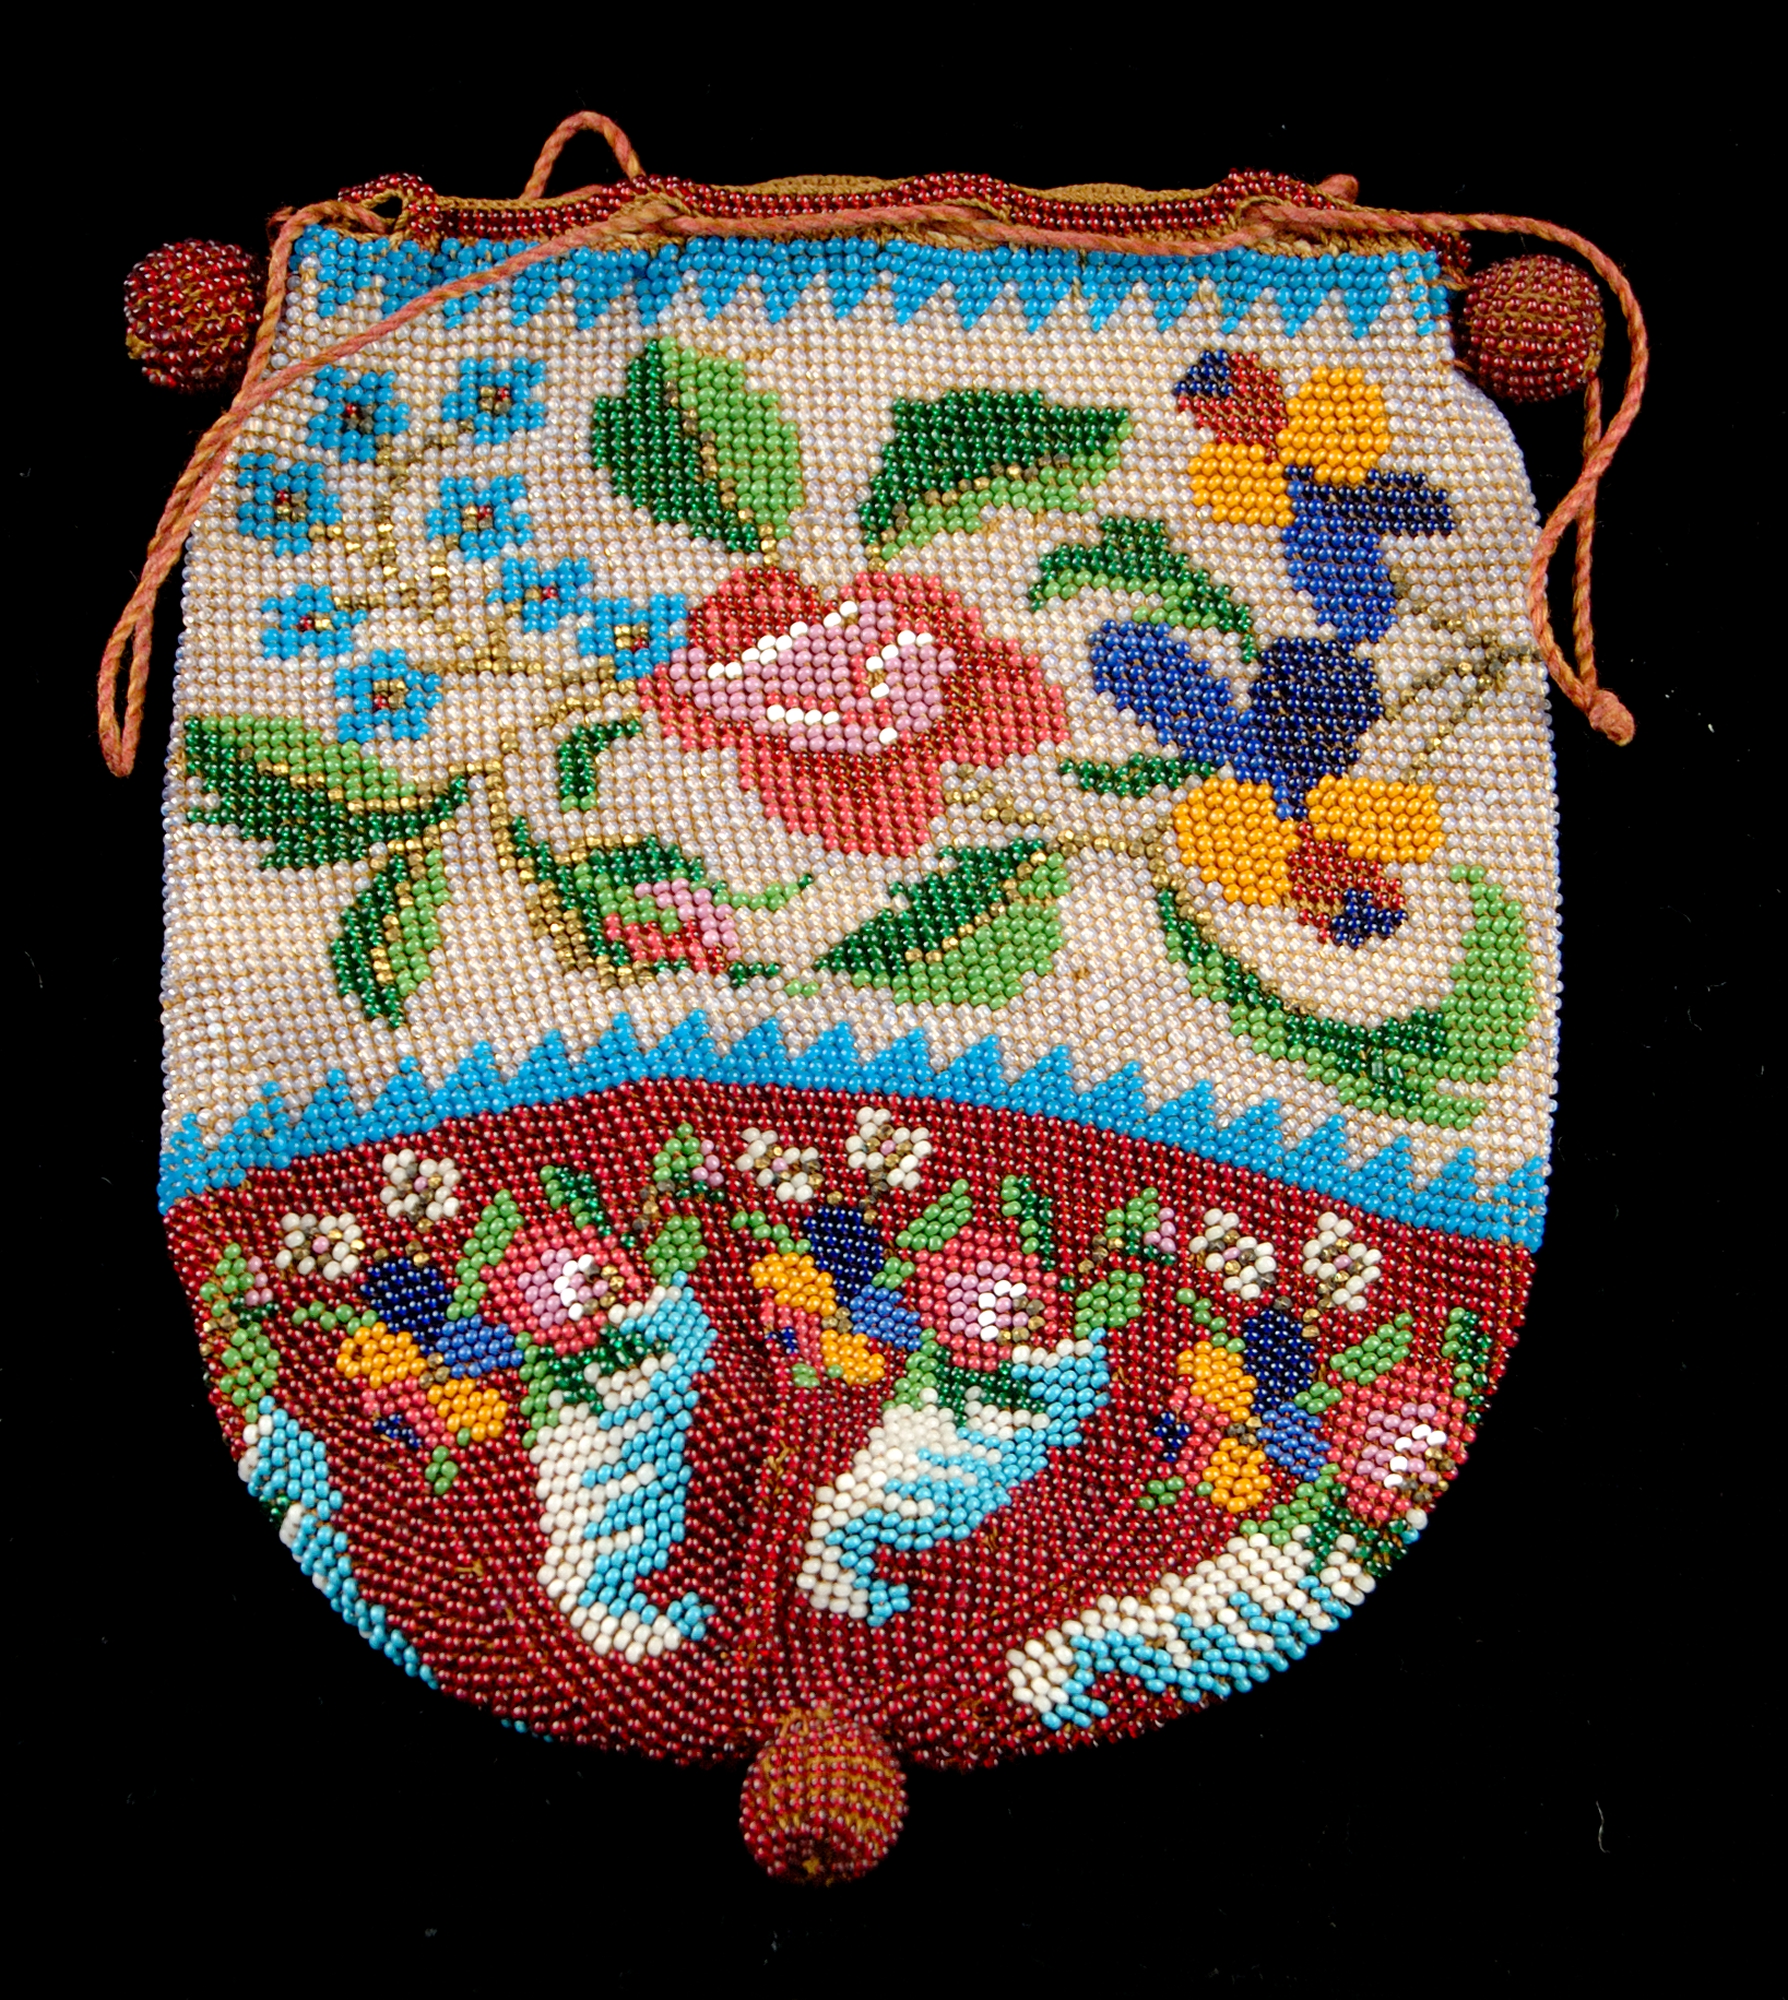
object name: pouch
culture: american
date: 1830-1860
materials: glass, leather, linen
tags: flowers